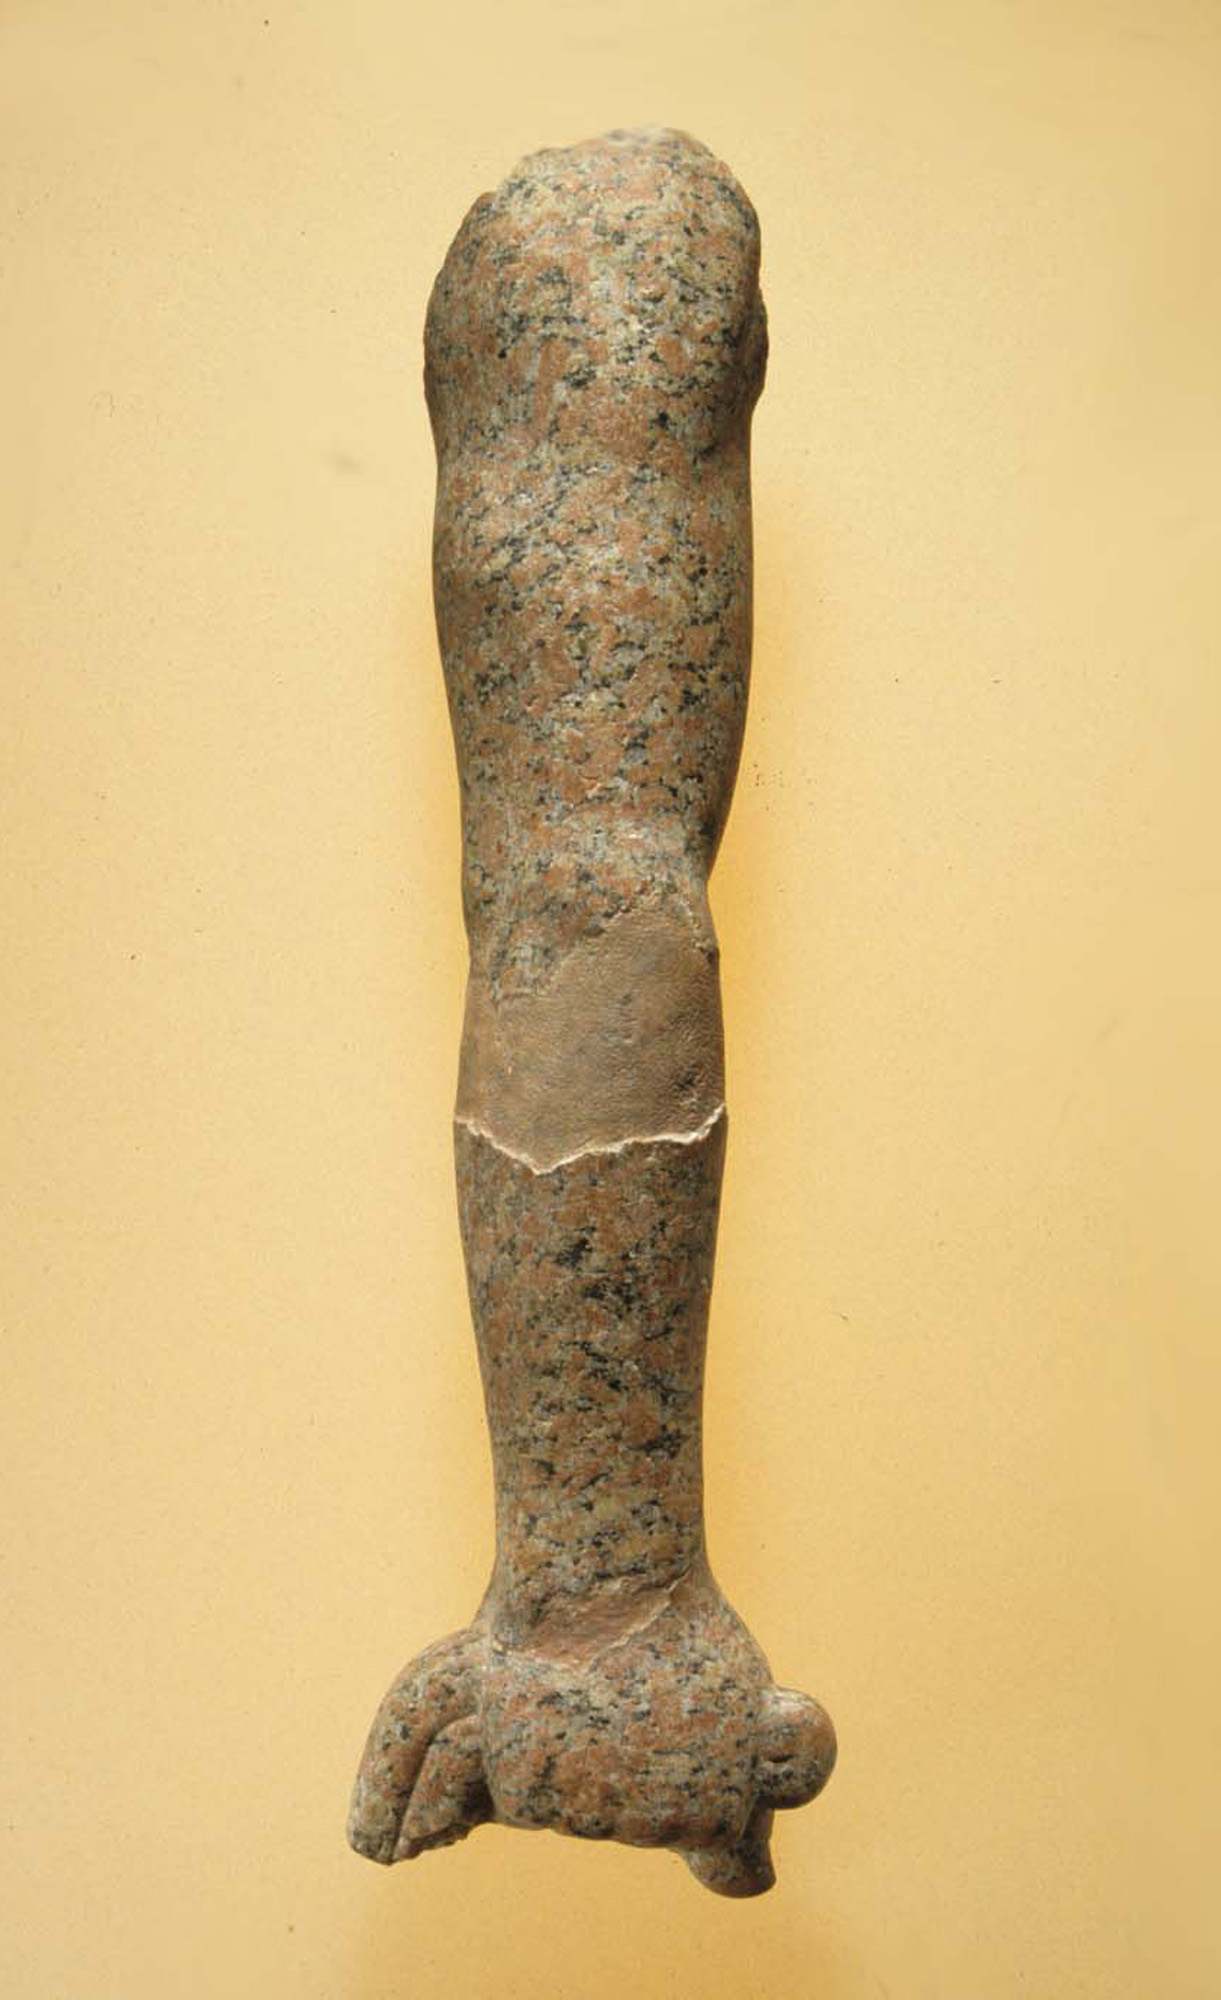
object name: statue arm fragment, life size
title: Arm of life-size statue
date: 1961-1917 BCE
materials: granite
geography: egypt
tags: hands